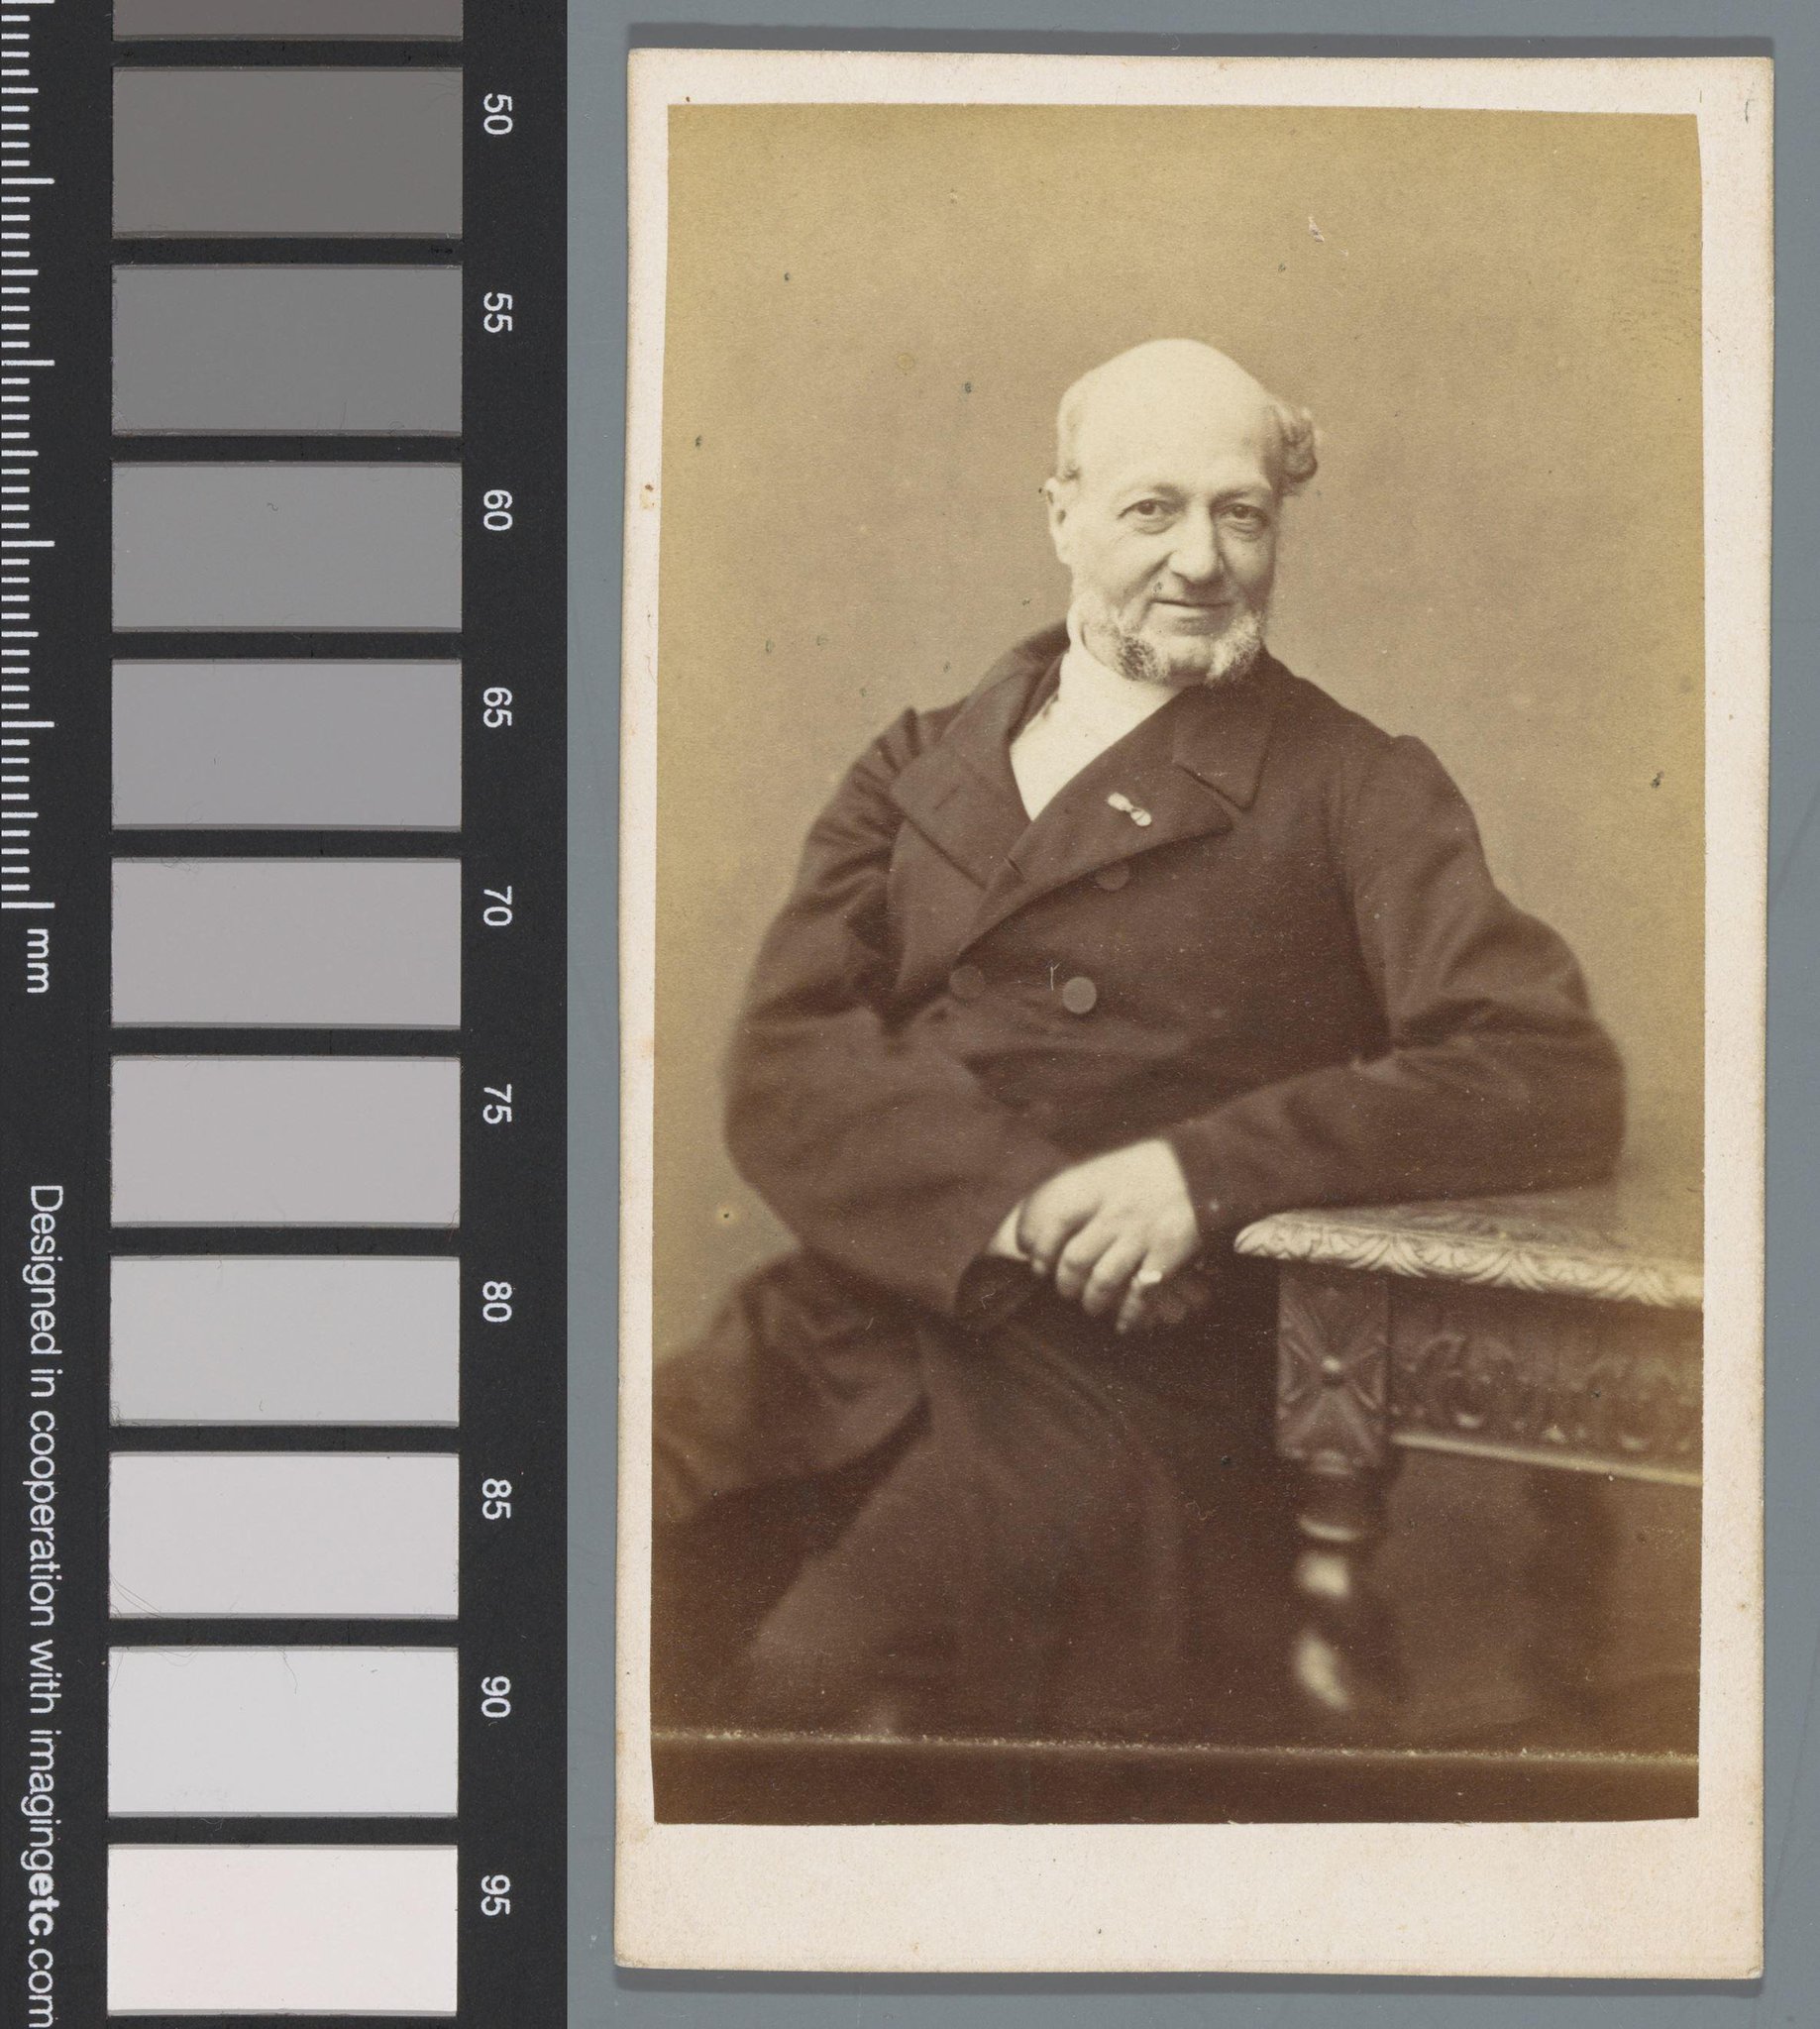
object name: carte de visite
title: Portret van Dr. Henri Blatin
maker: Anonymous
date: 1855-1869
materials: cardboard, paper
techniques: albumen print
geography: paris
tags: historical persons, old man, veterinarian, paris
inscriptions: inscription: ‘Le Docteur Blatin,/ à Paris./ Socr. de la Soc. pour la pro-/ tection des animaux’